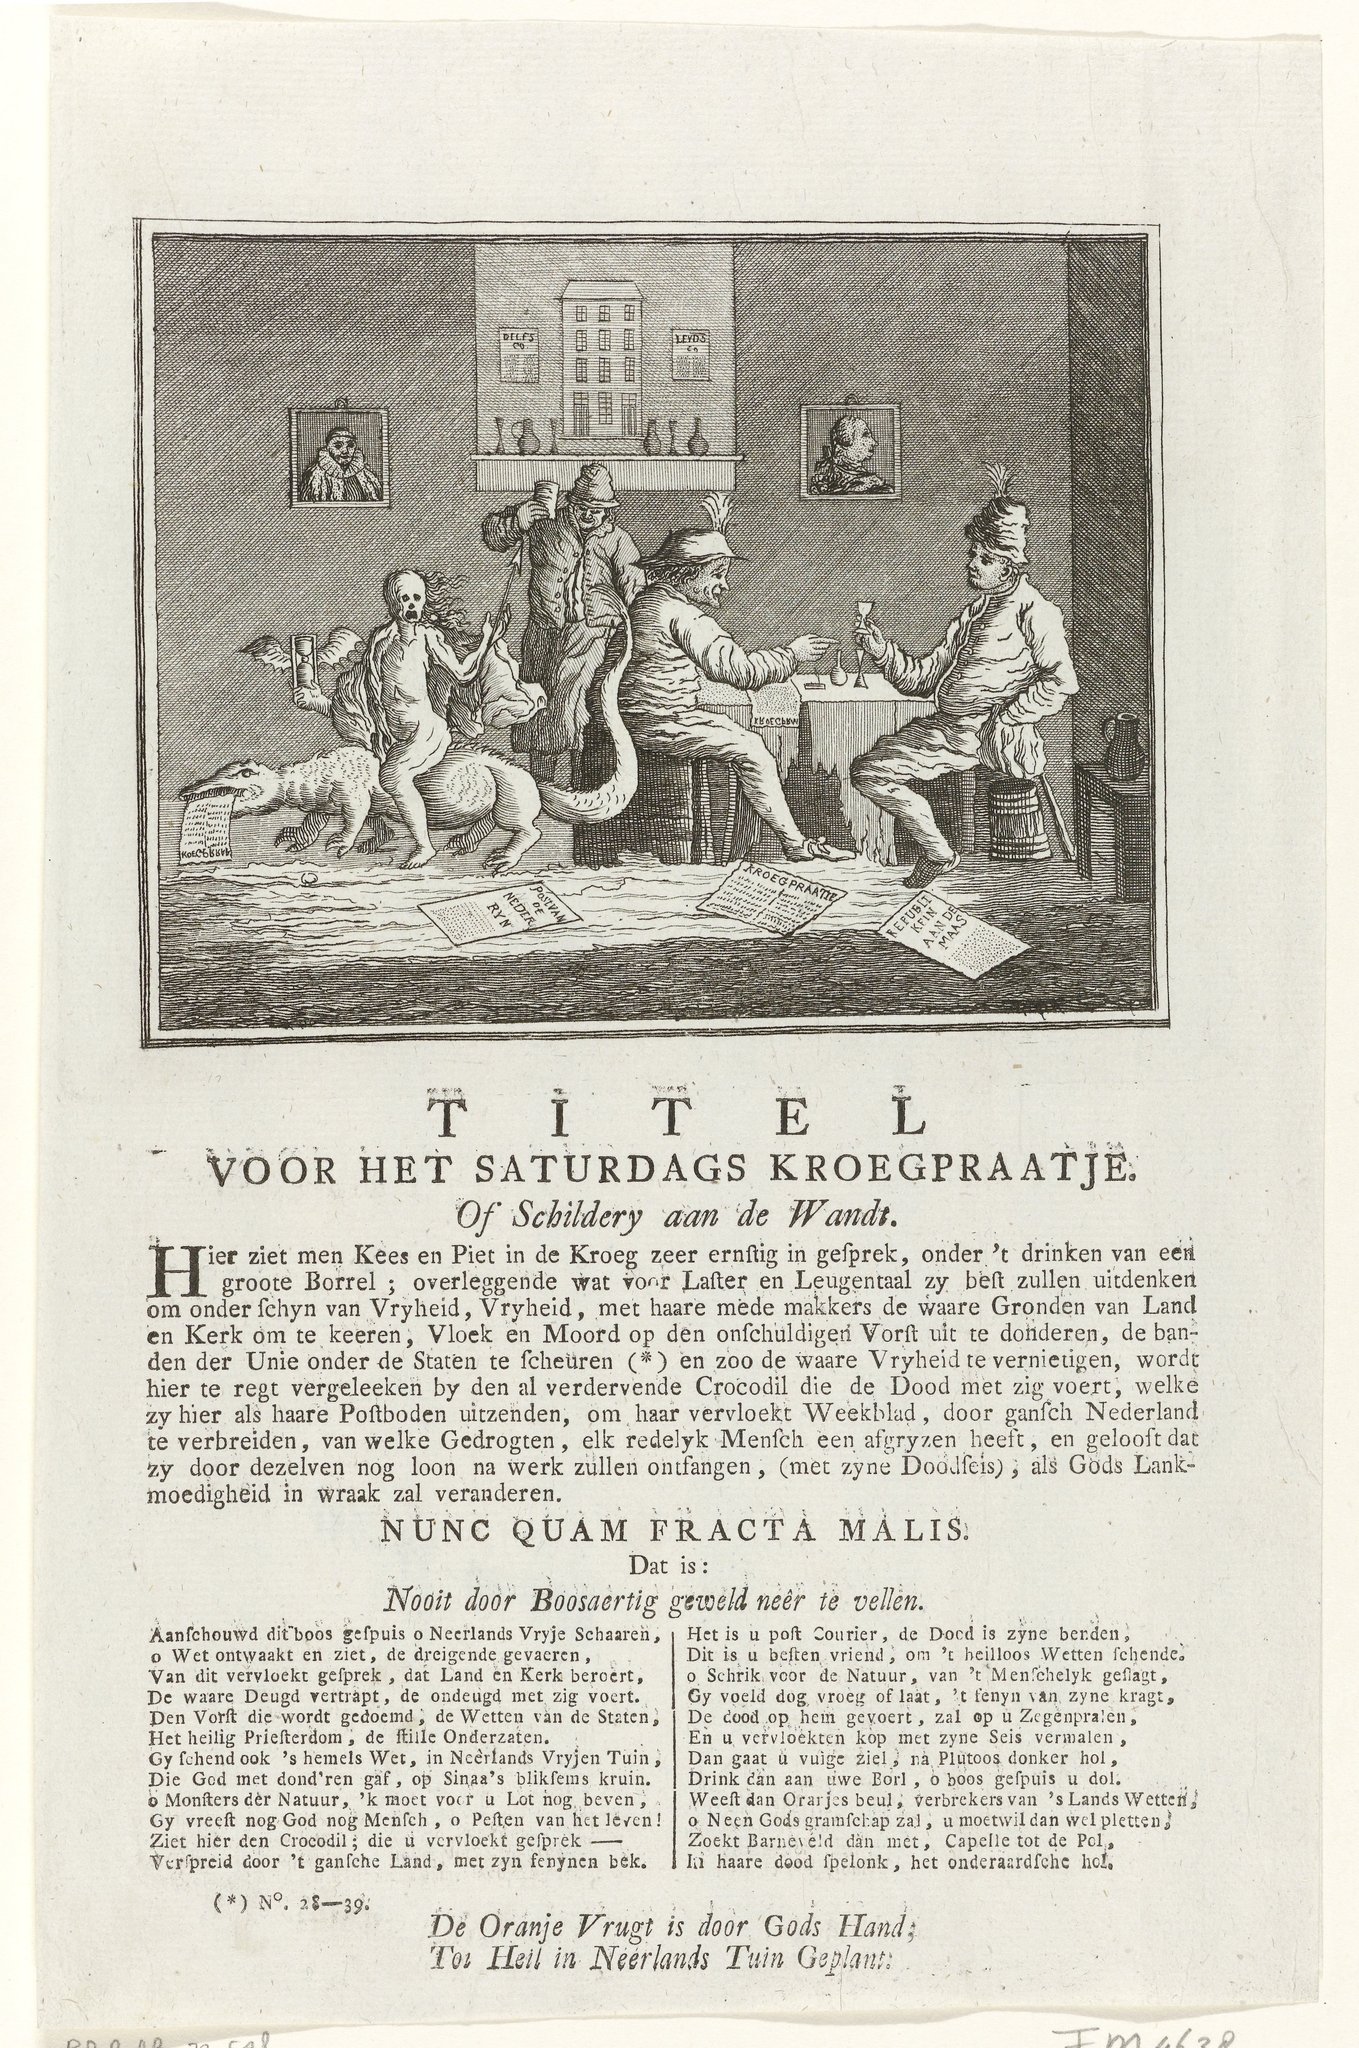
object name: print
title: Spotprent op het blaadje Saturdags Kroegpraatje, 1786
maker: Anonymous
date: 1786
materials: paper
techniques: engraving, etching, letterpress printing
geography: northern netherlands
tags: the hague, william v (prince of orange), delft, william i (prince of orange), inn, coffee-house, public house, etc., rotterdam, patriots (1780-1795)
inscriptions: collector's mark: Lugt 2228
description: Spotprent op het Rotterdams patriots blaadje Saturdags Kroegpraatje dat op 4 maart 1786 voor het eerst verscheen. In een herberg zitten twee patriotische werklieden onder het drinken van een borrel te praten. Links rijdt de Dood op een krokodil. Op degrond liggen patriotse bladen: 'het Kroegpraatje', 'Post voor de Nederrijn' en 'Republikein aan de Maas'. Aan de muur hangt een schilderij waarop een groot huis, geflankeerd door portretten van Willem I en Willem V. Op het blad onder de plaat een uitleg en een vers.